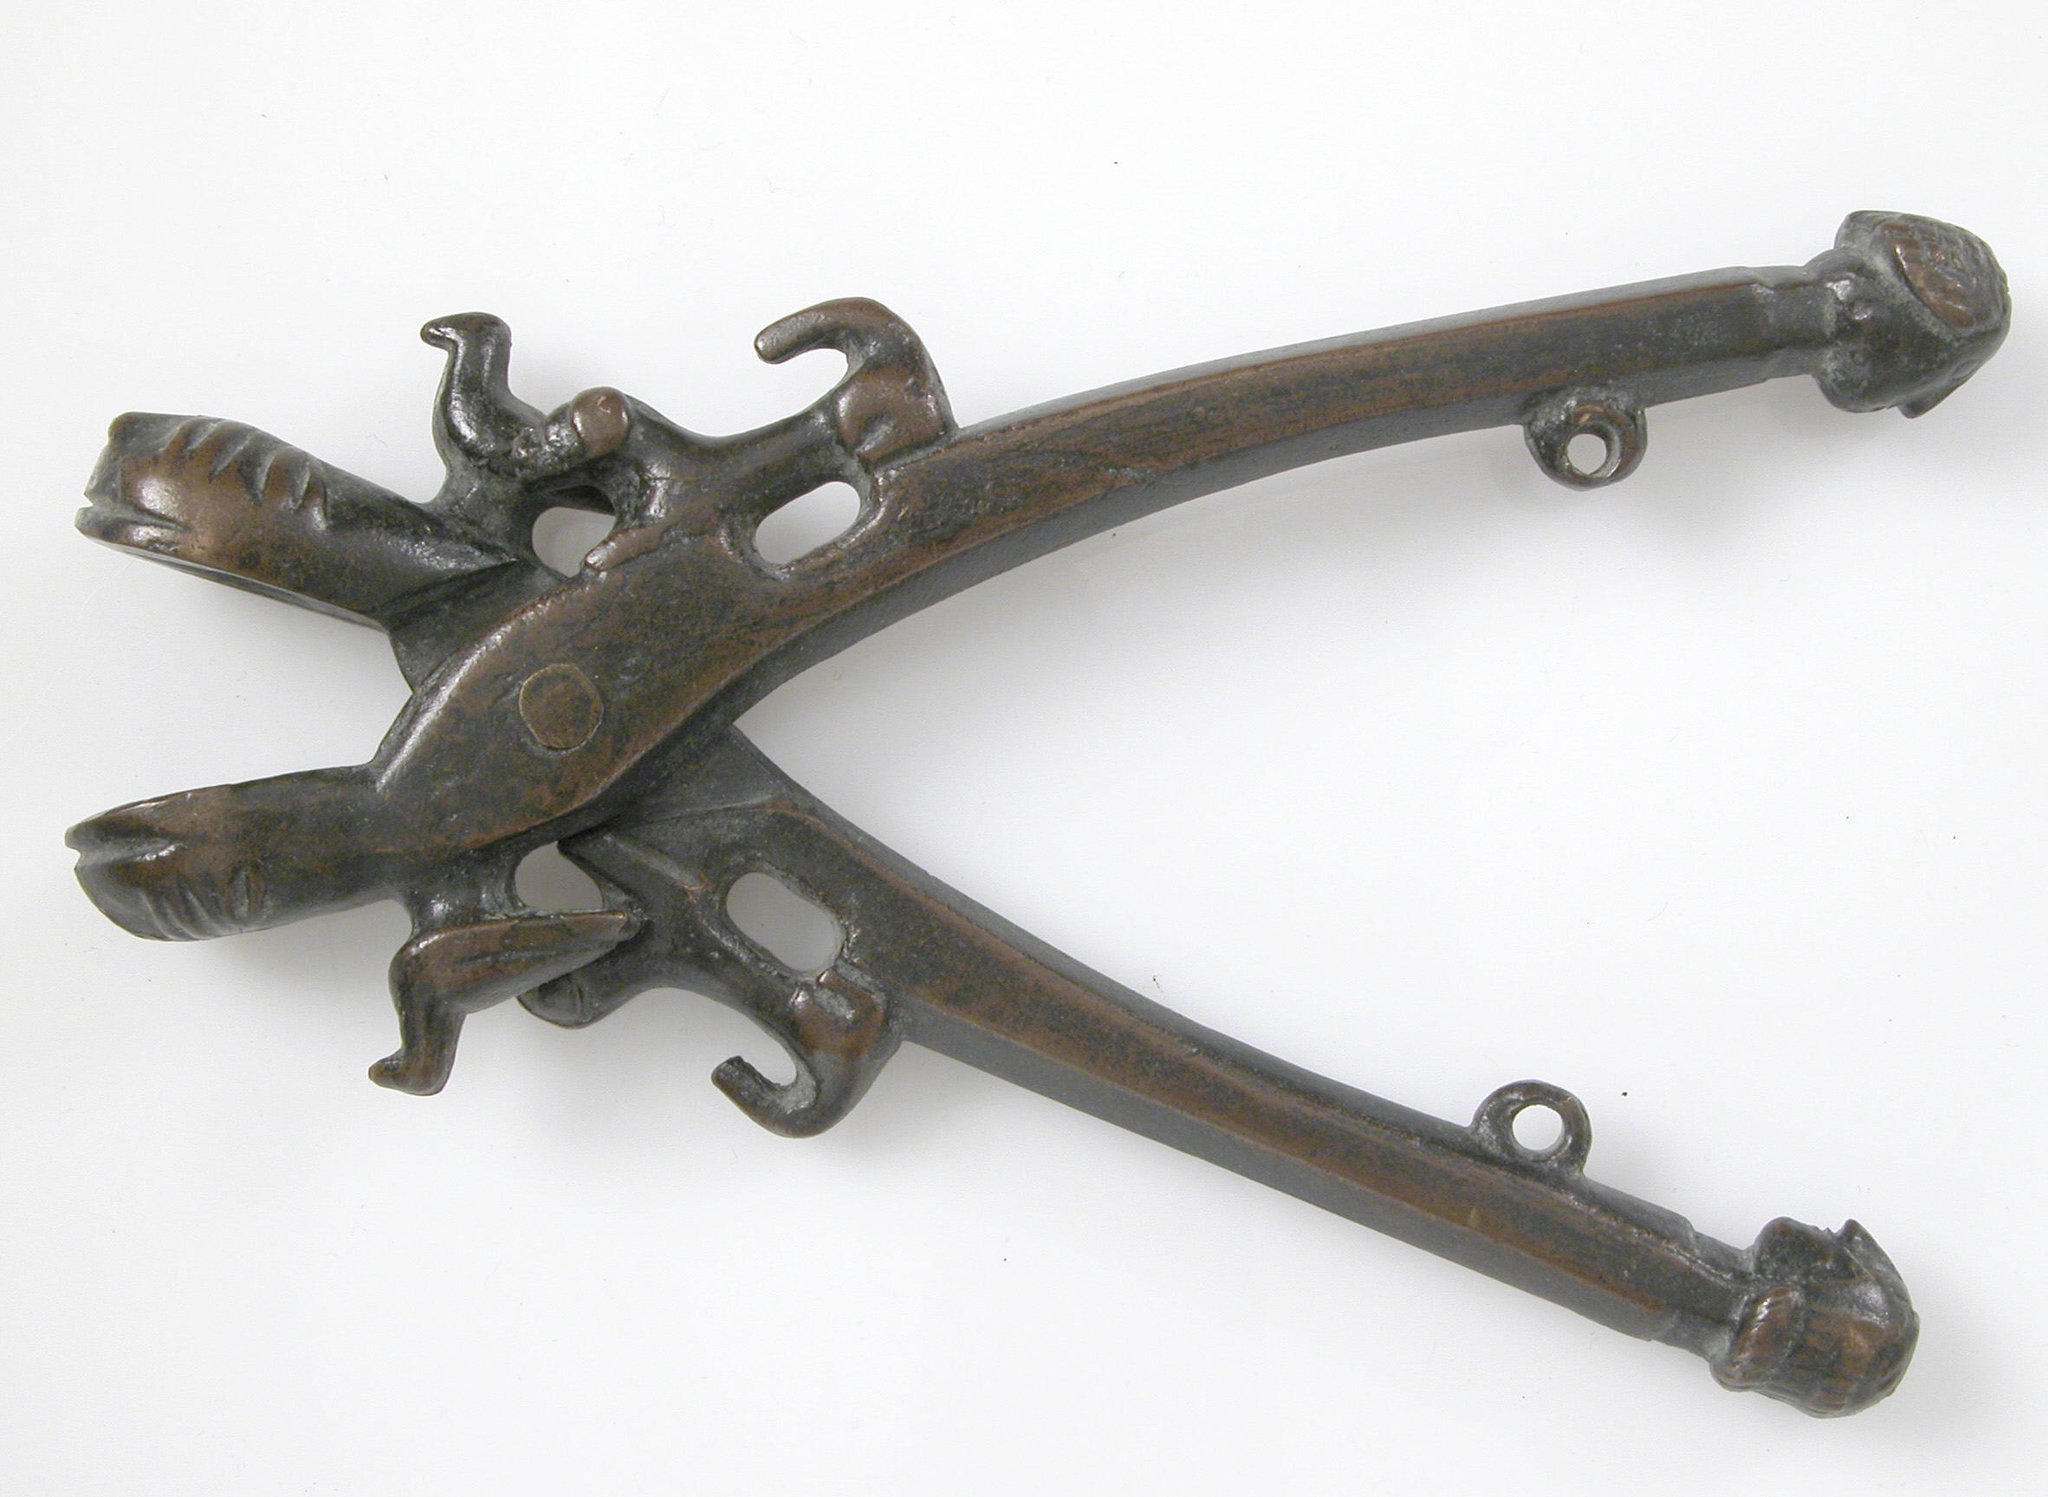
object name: nutcracker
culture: german or south netherlandish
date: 1401-1433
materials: copper alloy